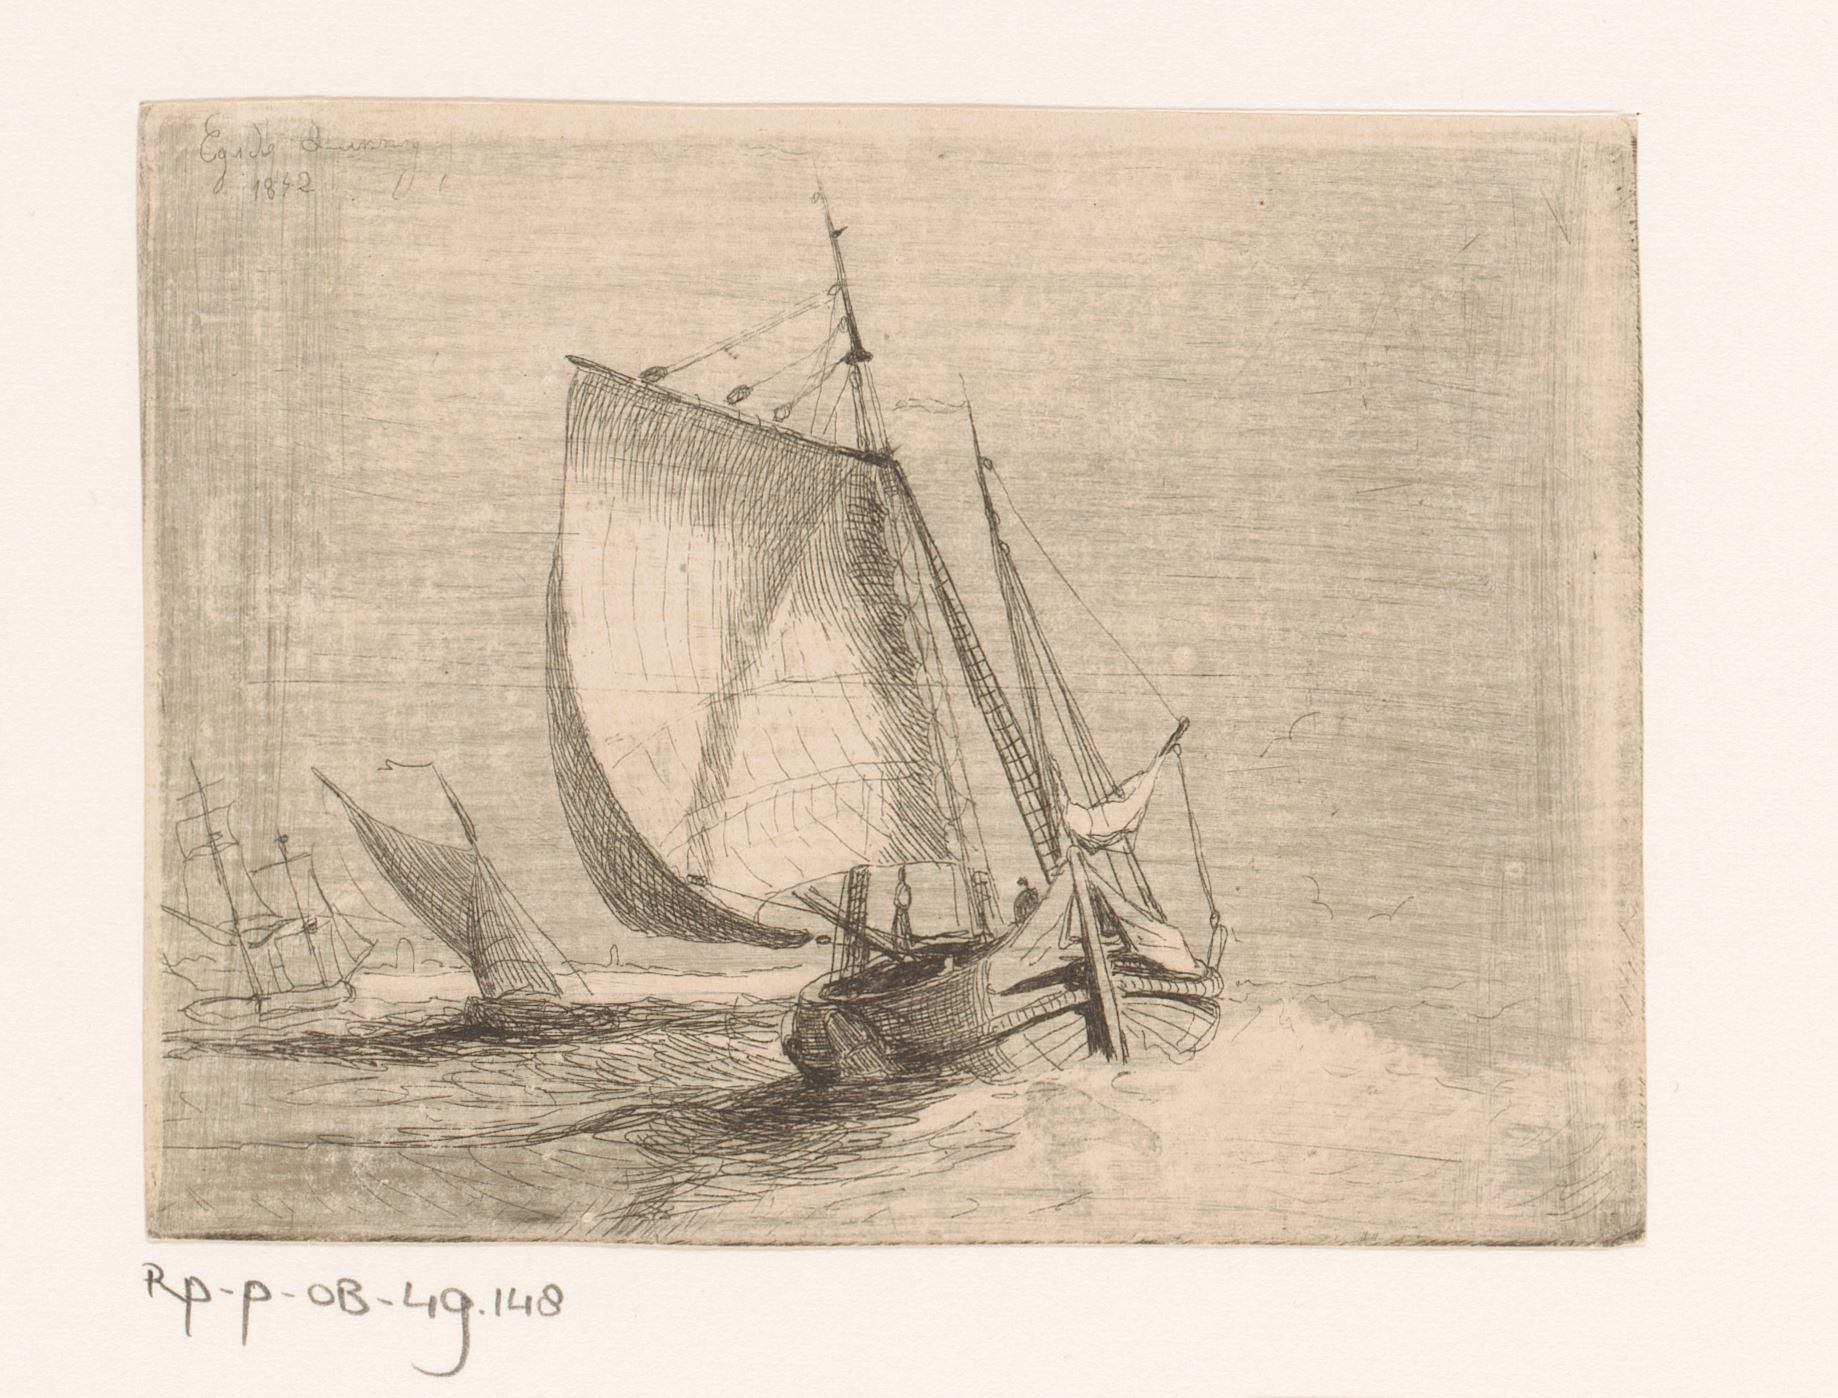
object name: print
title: Vissersboot op woelig water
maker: egidius linnig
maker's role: draughtsman, print maker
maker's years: 1821-1860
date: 1842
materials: paper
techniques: etching, intaglio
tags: sailing-ship, sailing-boat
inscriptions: collector's mark: Lugt 2228